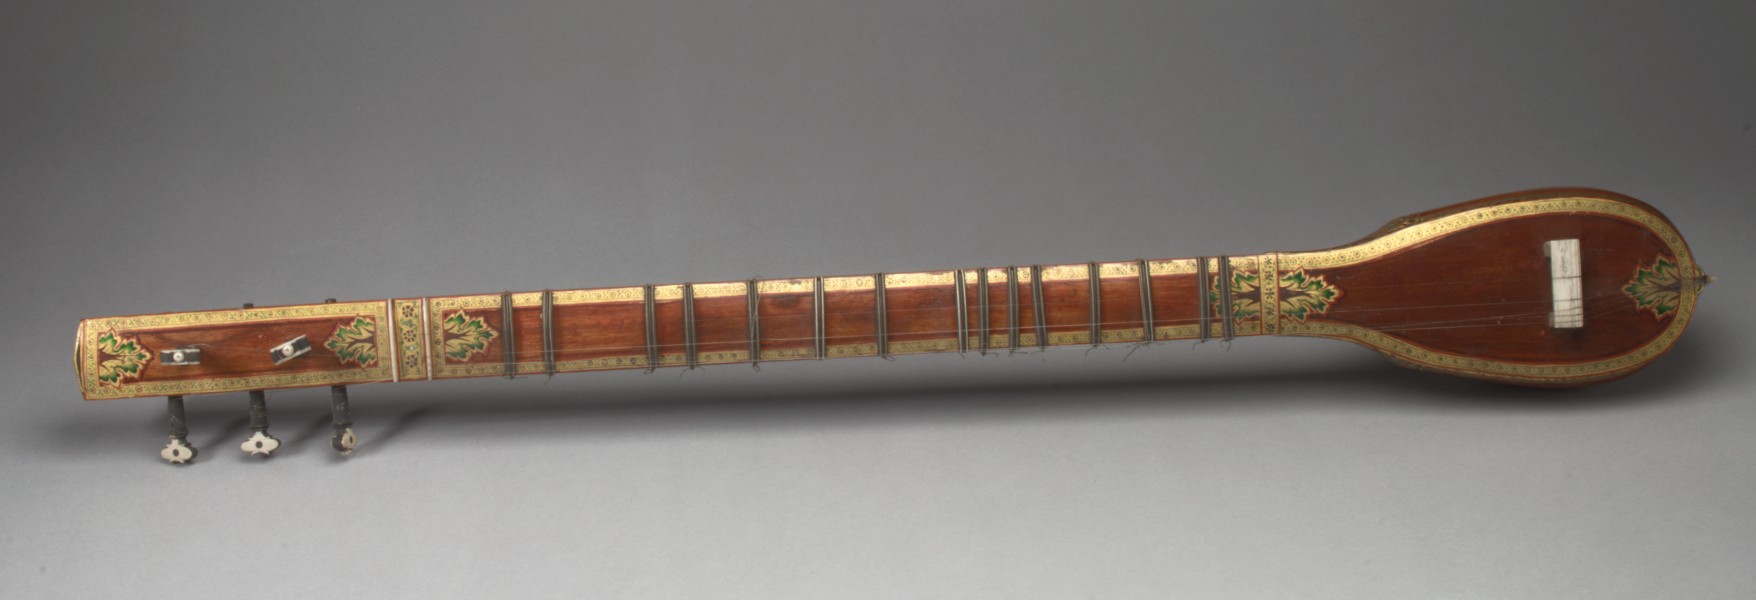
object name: sitar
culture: indian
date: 1867-1900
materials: wood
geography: india